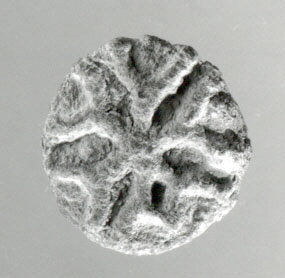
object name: stamp seal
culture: bactria-margiana archaeological complex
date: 2333-1668 BCE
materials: copper alloy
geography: bactria-margiana